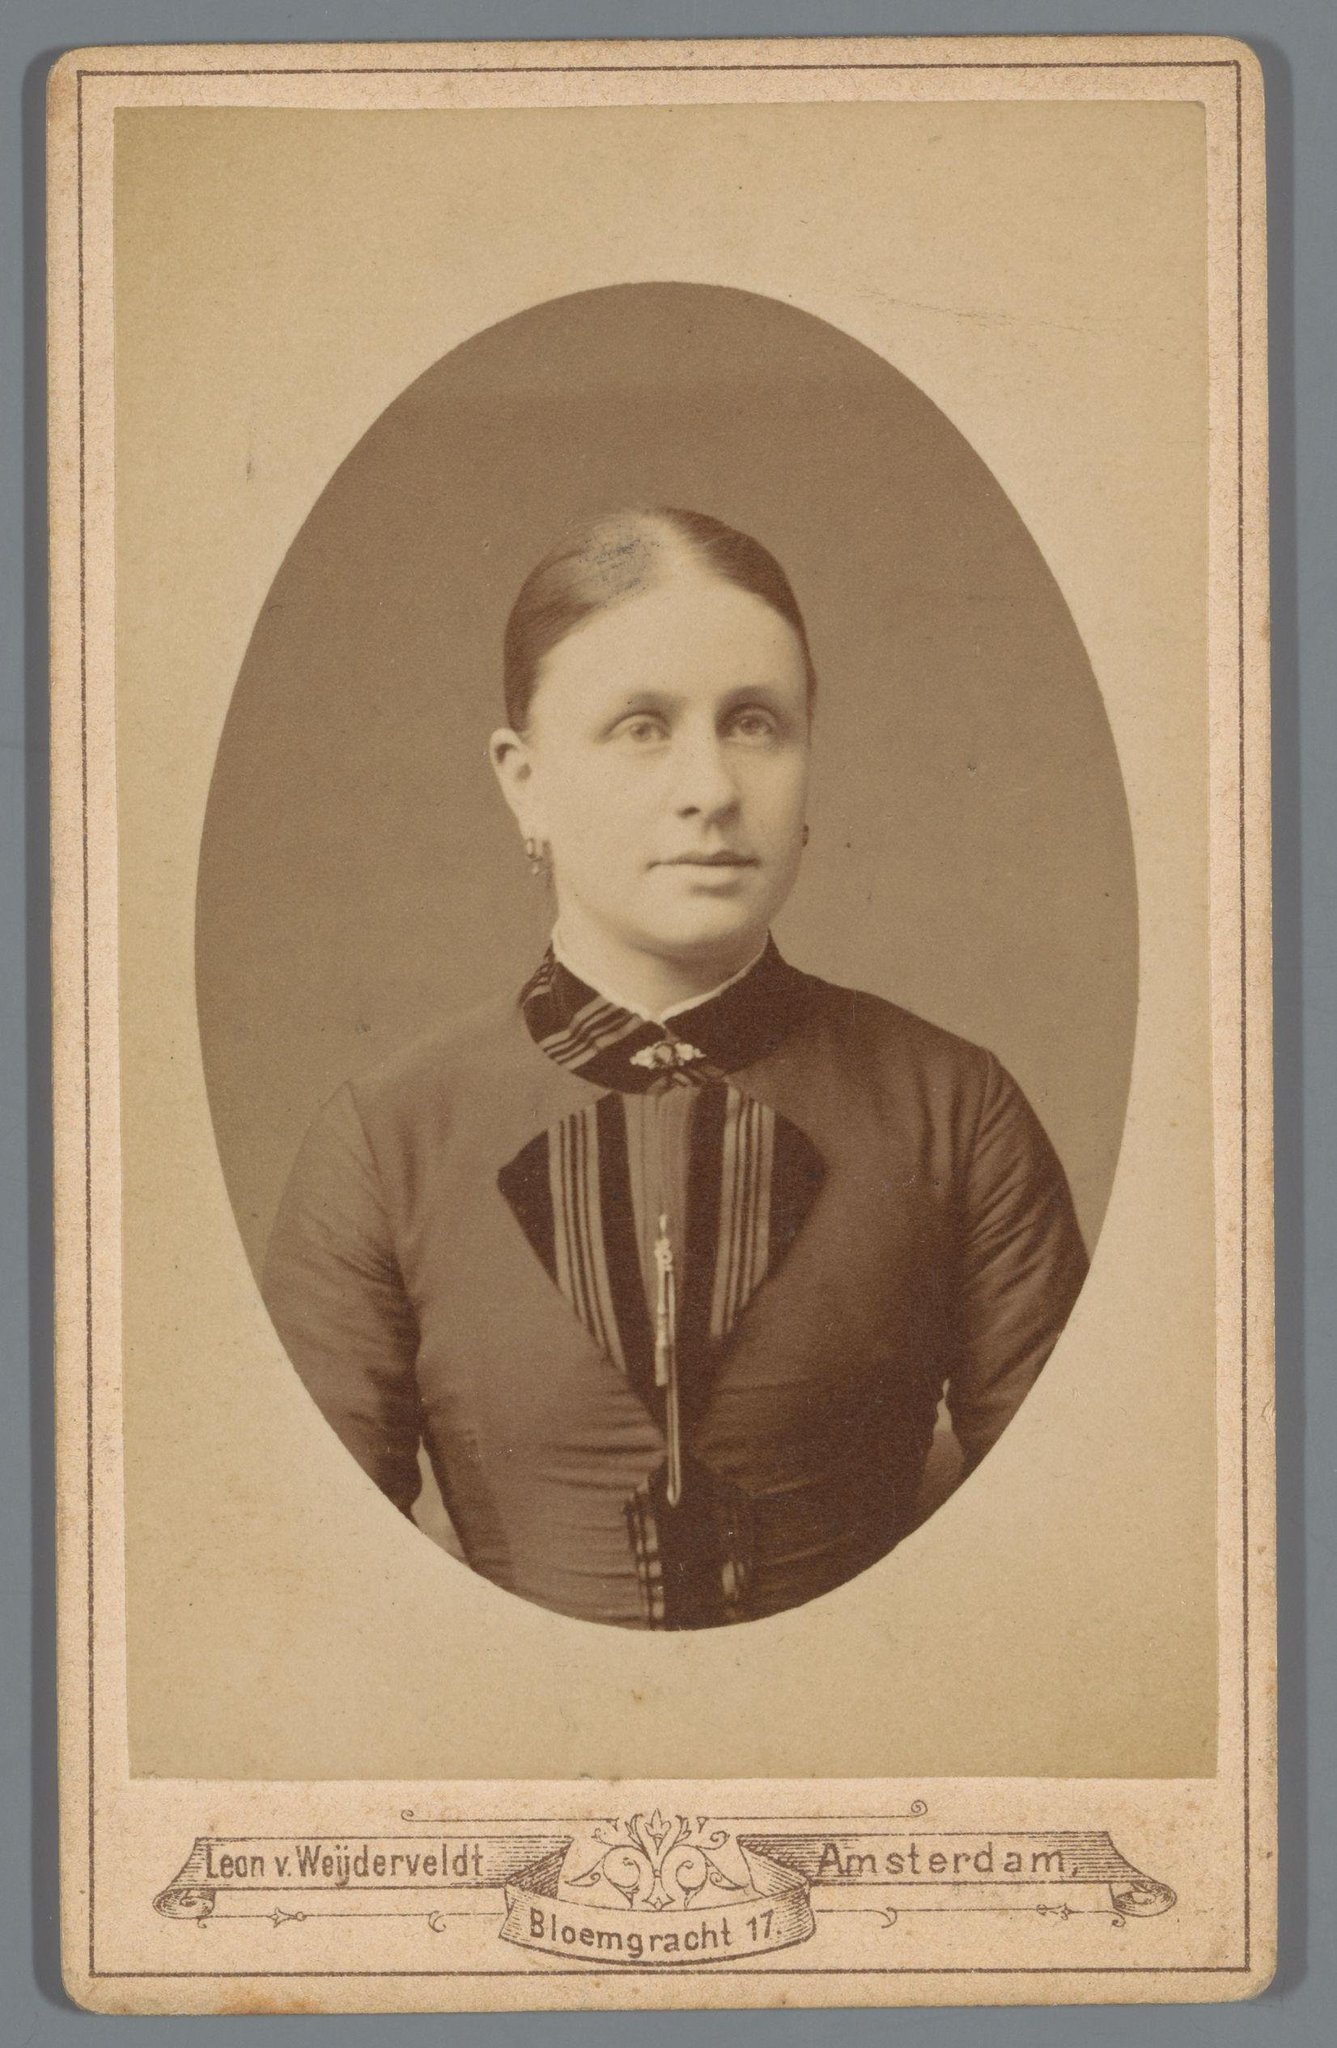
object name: carte de visite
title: Portret van een onbekende vrouw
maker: leon a. van weijderveldt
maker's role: fotograaf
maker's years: 1814-1888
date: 1868-1888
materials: cardboard, paper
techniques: albumen print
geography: amsterdam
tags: adult woman, anonymous historical person portrayed, amsterdam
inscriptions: inscription: ‘Leon v. Weijderveldt/ Bloemgracht 17./ Amsterdam.’, inscription: ‘Photographische Inrichting/ van/ Leon van Weijderveldt/ Bloemgracht 17, b.d. Prinsengracht,/ Amsterdam./ Specialiteit in Vergrootingen.’